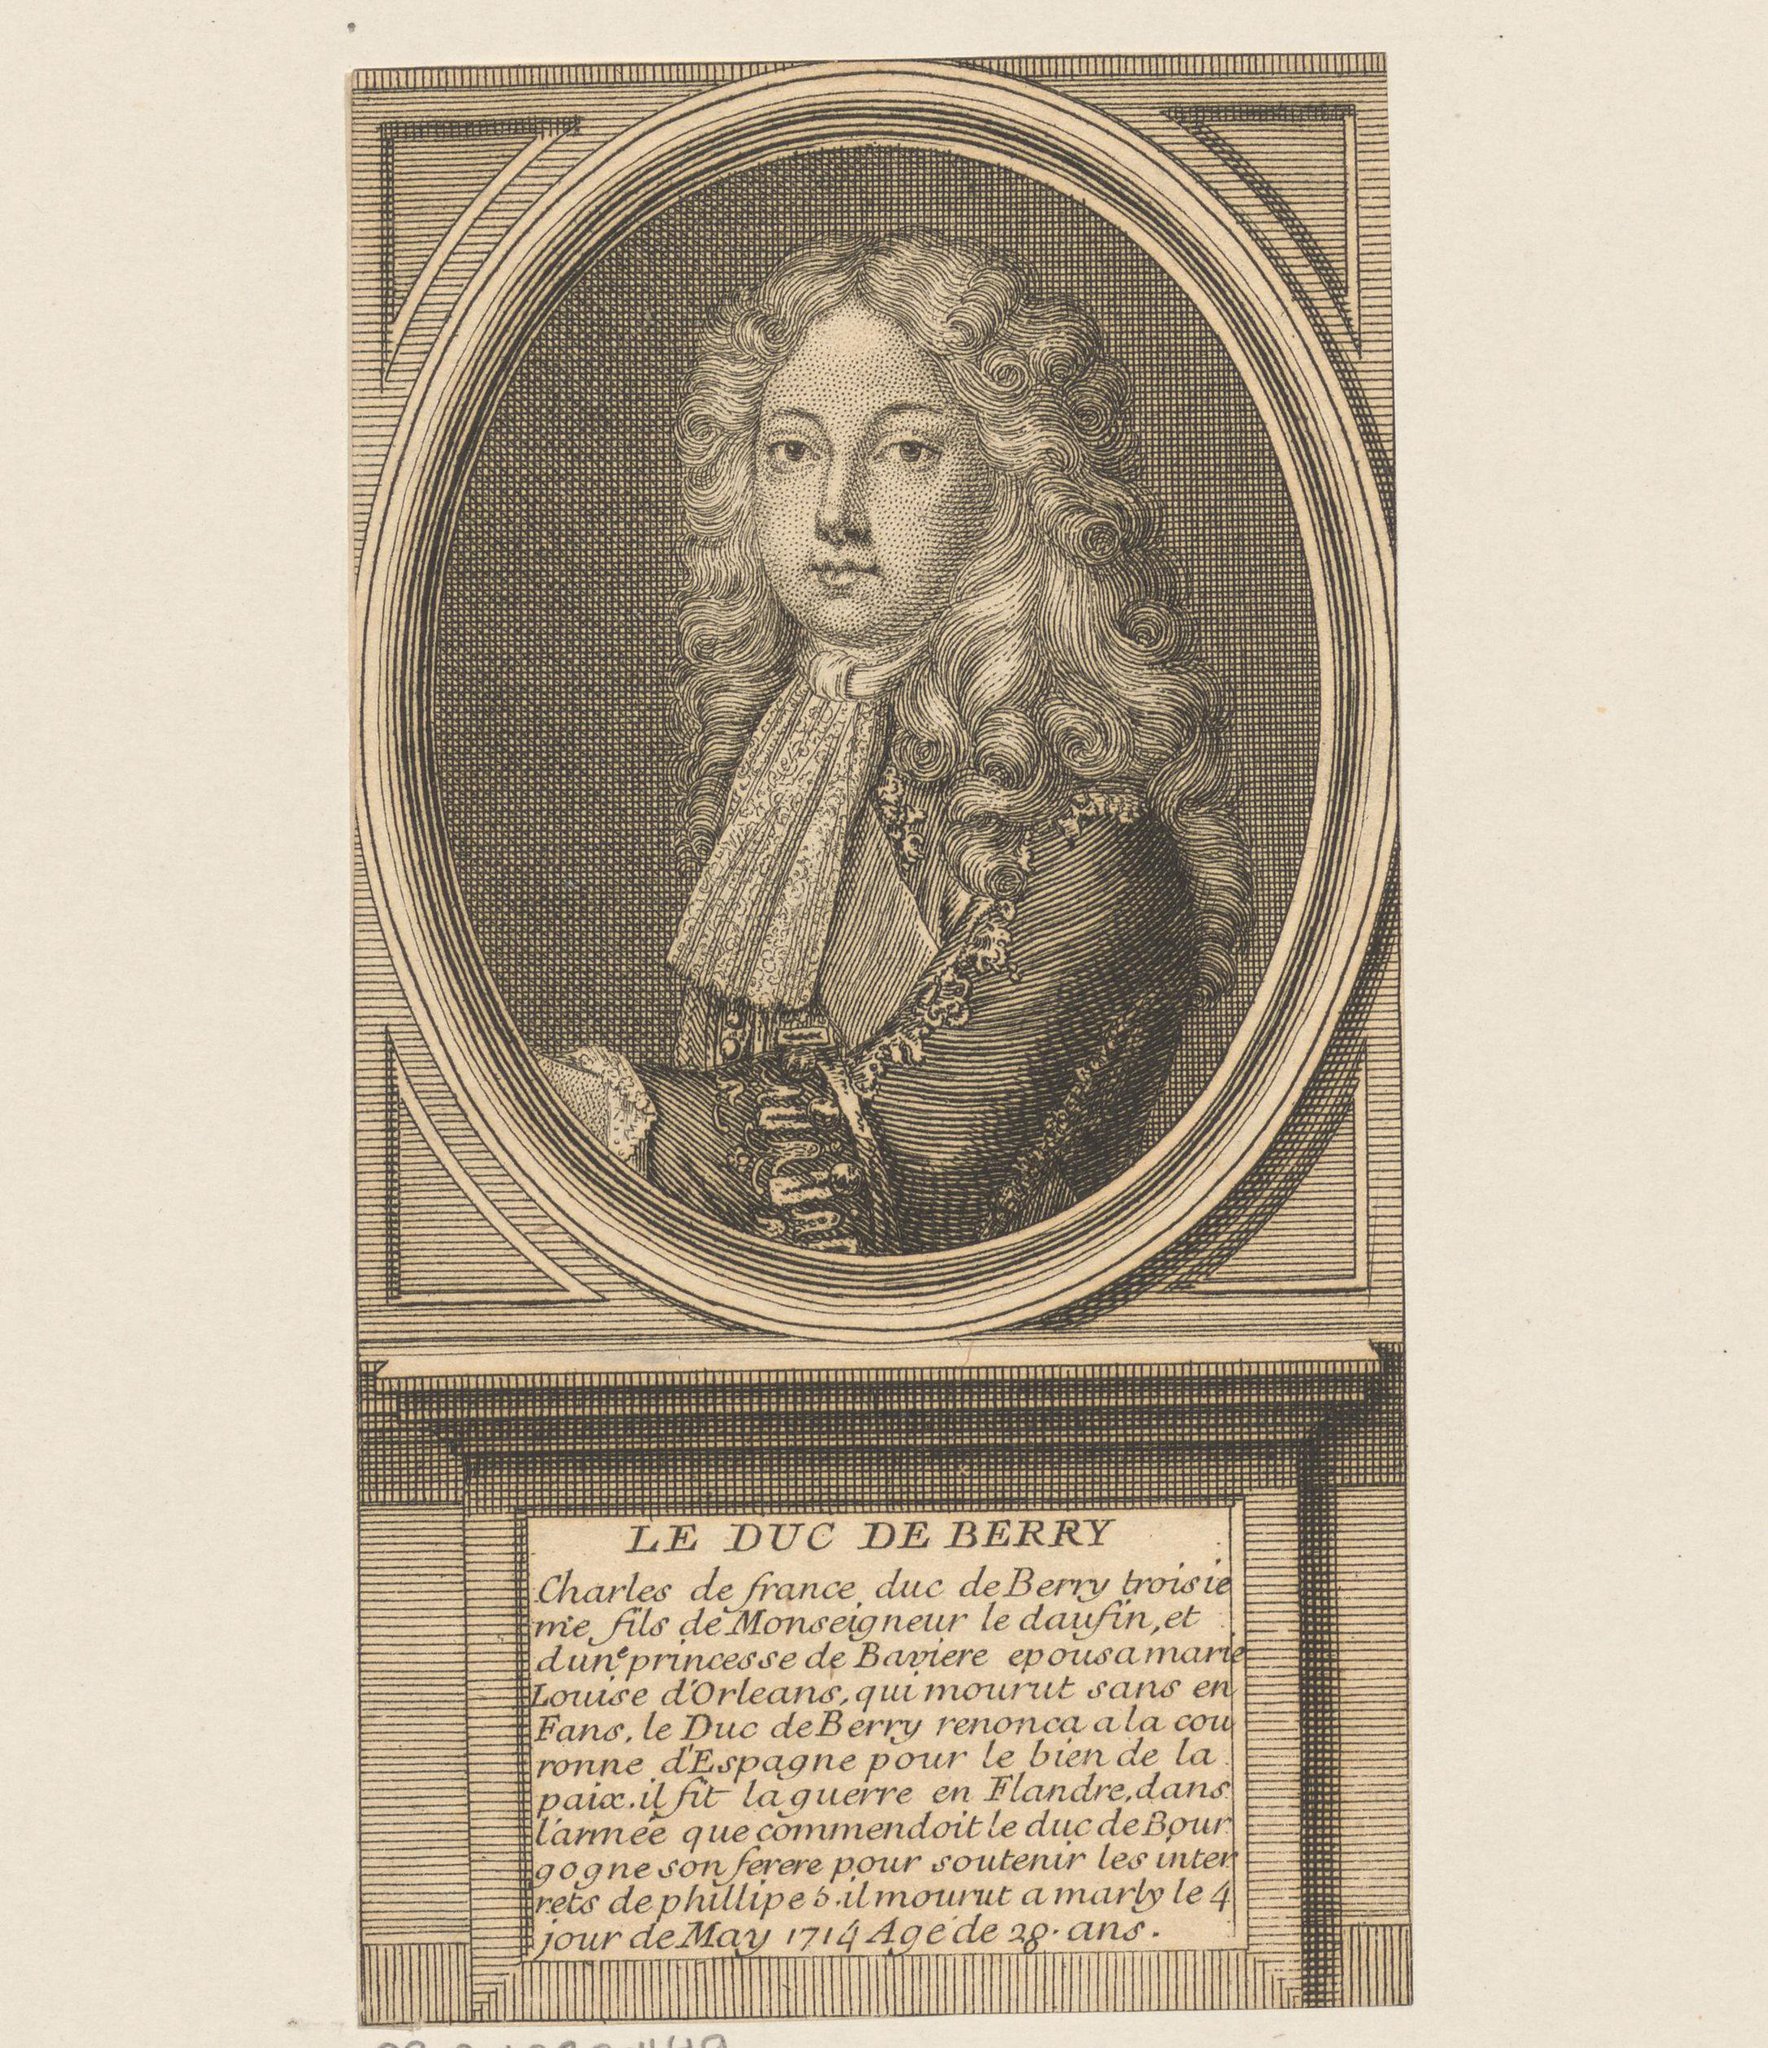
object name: print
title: Portret van Karel van Frankrijk, hertog van Berry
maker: Anonymous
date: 1714-1749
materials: paper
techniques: engraving, etching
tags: historical persons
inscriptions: collector's mark: Lugt 2228